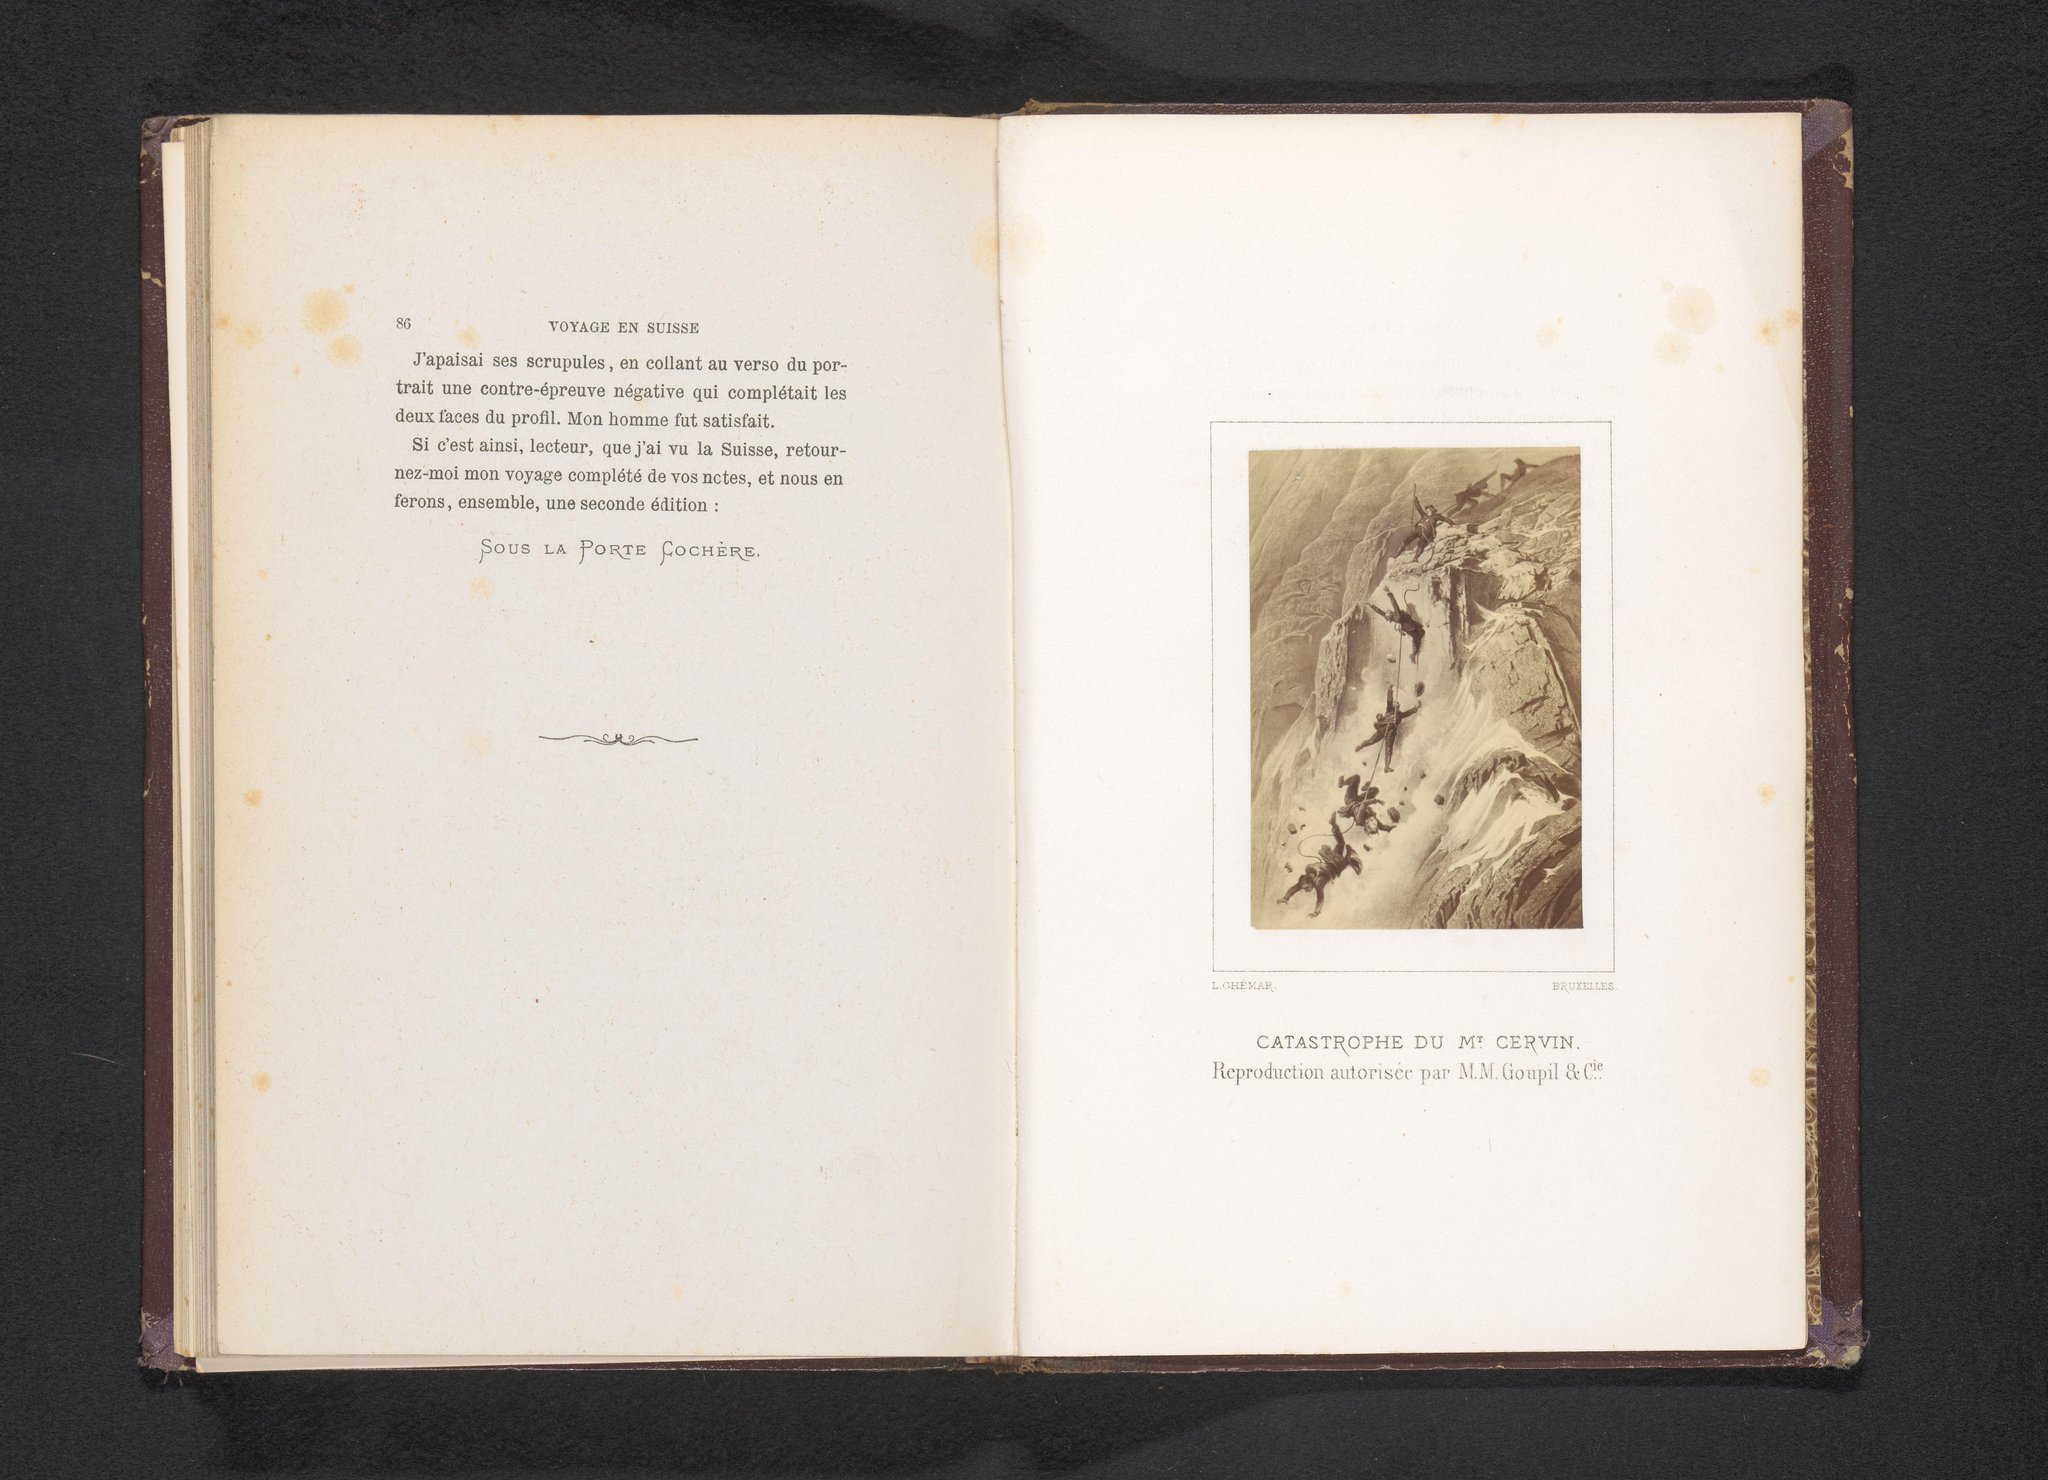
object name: reproduction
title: Catastrophe du Mt. Cervin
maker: Anonymous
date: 1863-1868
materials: photographic support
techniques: albumen print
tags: mountain climbing, mountaineering, falling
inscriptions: inscription: ‘Reproduction autorisée par M.M. Goupil & Cie.’, inscription: ‘Bruxelles’